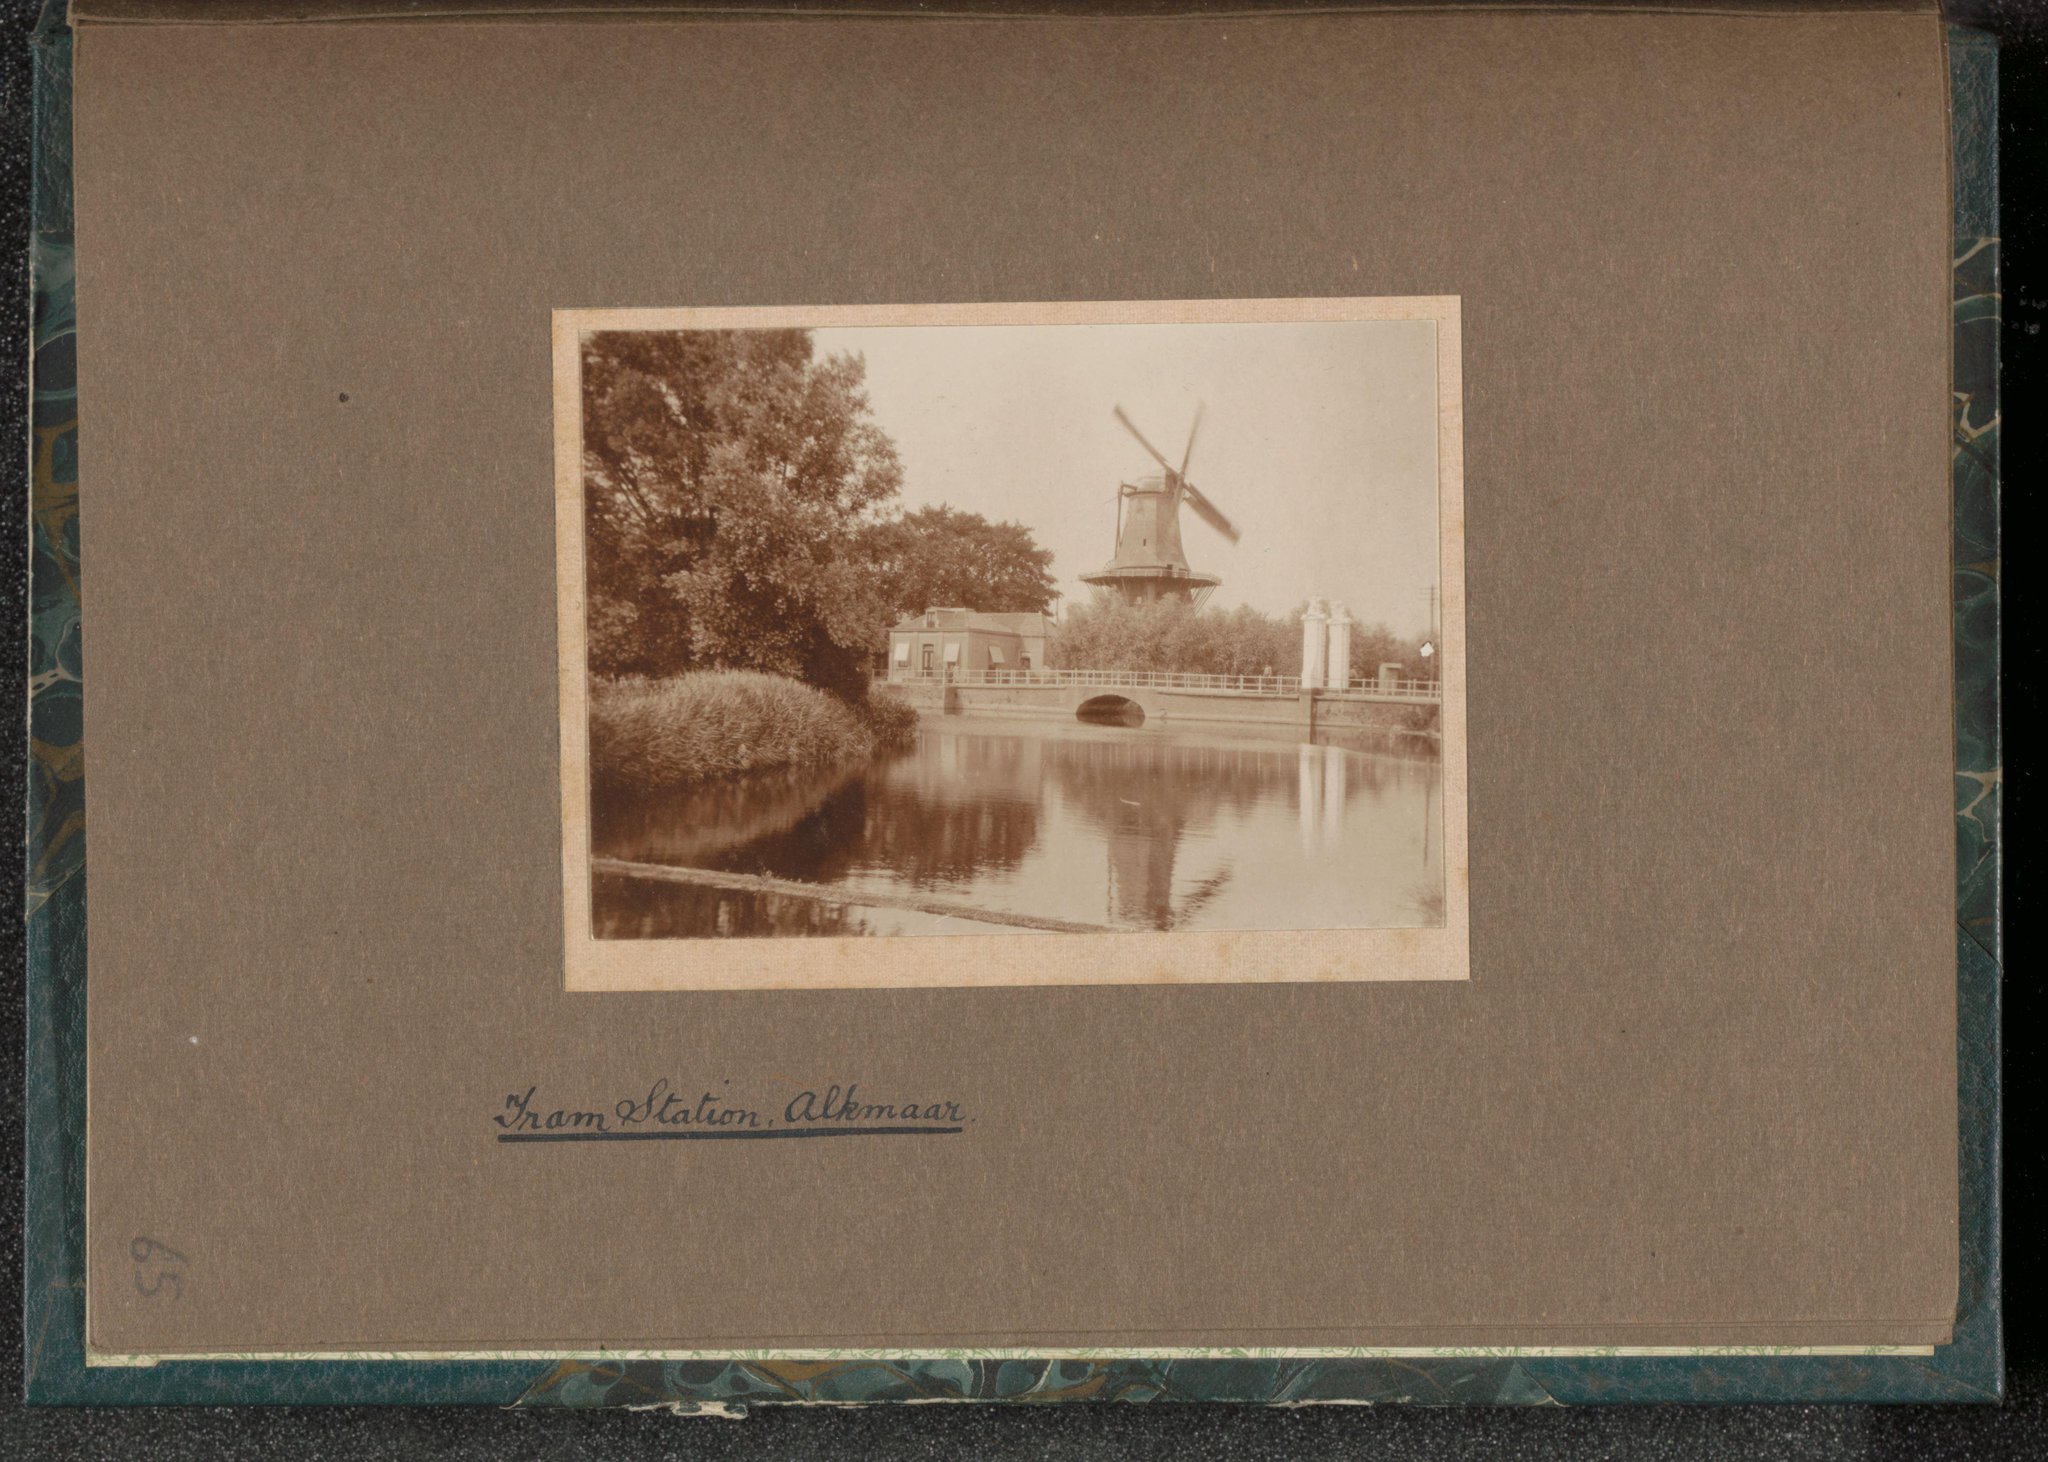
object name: photograph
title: Windmolen De Wachter, een commieskantoor annex woning en een tramspoor langs het Gat van Bagge te Alkmaar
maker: Anonymous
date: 1912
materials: photographic support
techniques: gelatin silver print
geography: alkmaar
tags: tramway, tram, (other) buildings, constructions ~ railway, tramway, canal, windmill in landscape, travelling; tourism, station; shelter (railway, tramway)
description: Onderdeel van Fotoalbum van de excursie naar Nederland van de Britse amateurfotografenvereniging P.C.U.K.